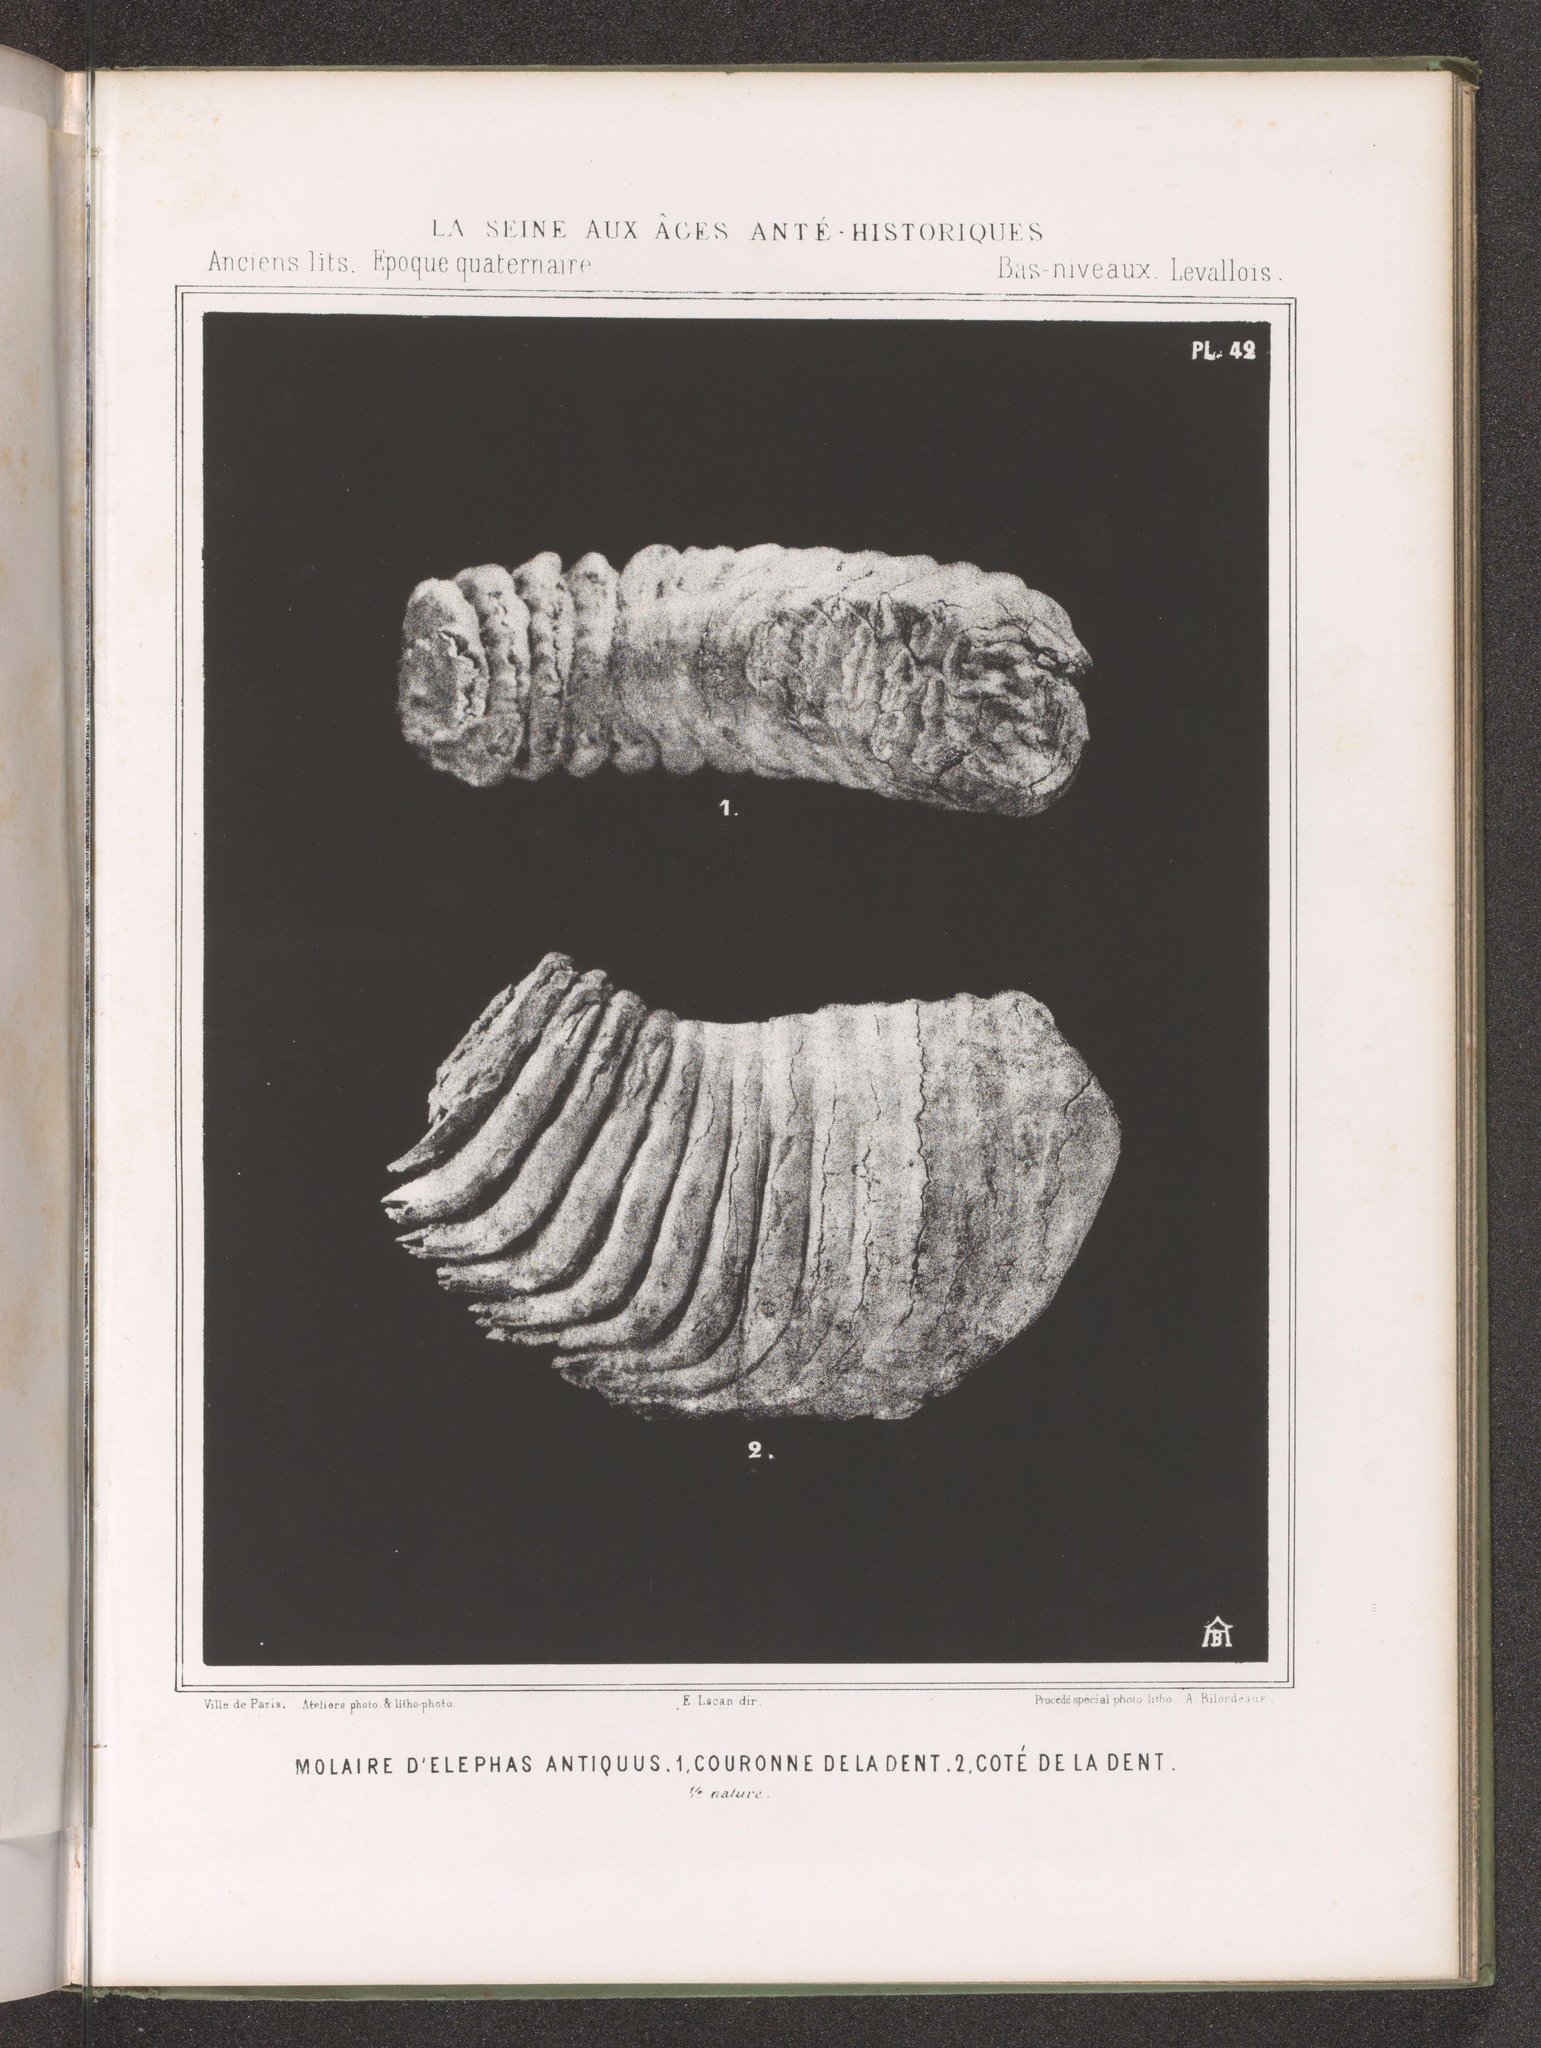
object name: photomechanical print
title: MOLAIRE D'ÉLEPHAS ANTIQUUS. 1. COURONNE DE LA DENT. 2. COTÉ DE LA DENT. 1/2 nature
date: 1860-1869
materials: paper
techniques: photolithography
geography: paris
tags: animals (+ skeleton of an animal), palaeontology, france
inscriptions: monogram: ‘AB’, inscription: ‘Ville de Paris Ateliers photo & litho-photo. E. Lacan, dir. Procédé spécial photo-litho A. Bilordeaux.’, number: ‘Pl. 42’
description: Voor plek prent in boek: zie nummer onder 'Opschriften / Merken'.